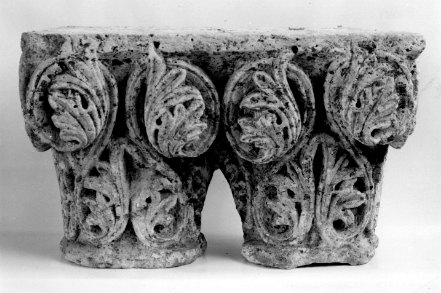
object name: capital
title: Double Capital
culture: french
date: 1101-1200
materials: limestone